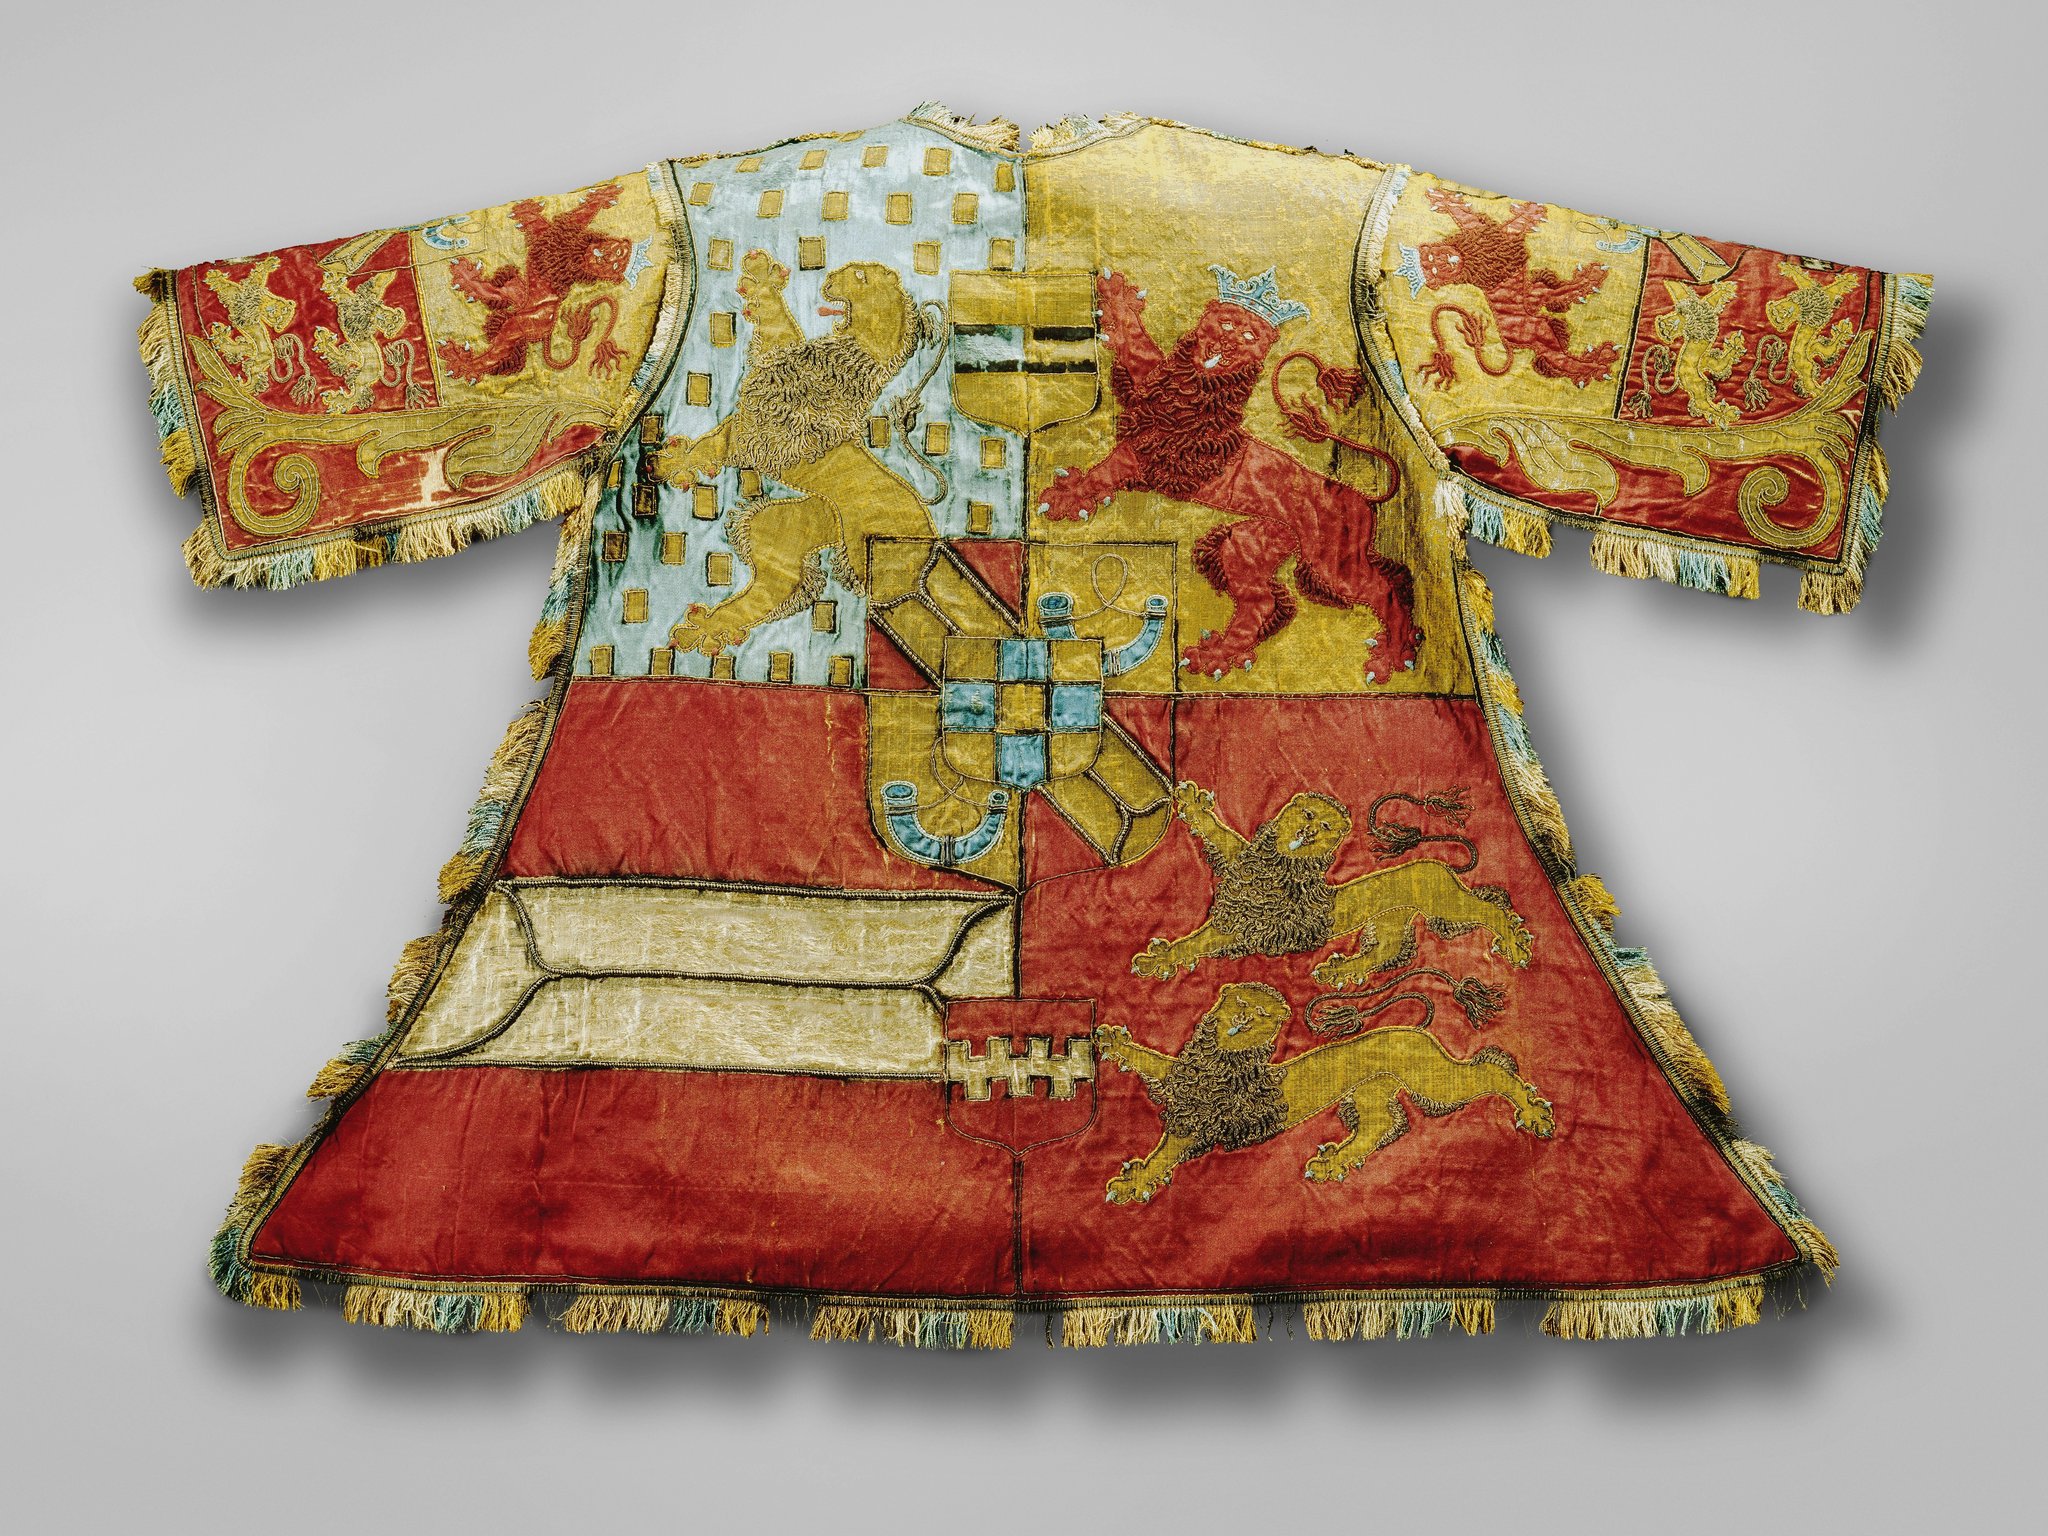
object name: coat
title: Heraldic tunic from the House of Orange-Nassau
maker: johan pietersz. smout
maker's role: lakenkoopman, schepen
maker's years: -1652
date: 1647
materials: linen, metal thread, silk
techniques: embroidered, sewing, weave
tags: frederick henry (prince of orange), the hague, willem iv (prins van oranje-nassau), coat of arms (symbol of sovereignty), netherlands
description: No article of clothing could be more symbolic: the arms of Prince Frederick Hendrick of Orange-Nassau are embroidered on the front, back, and sleeves. This ‘heraldic tunic’ was made for his state funeral in Delft on 10 May 1647. It was carried in the procession to demonstrate the deceased’s status and rank. Four such tunics were worn by heralds, and a fifth, symbolizing the dead prince, was borne aloft on a pole.